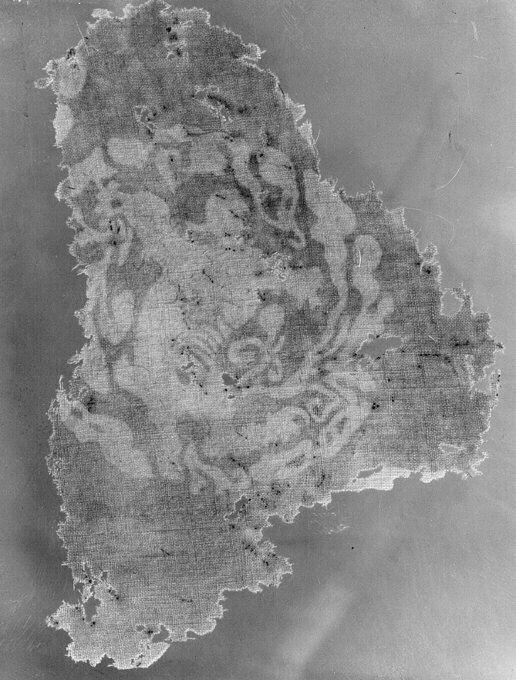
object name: fragment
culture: japanese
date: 701-800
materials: silk